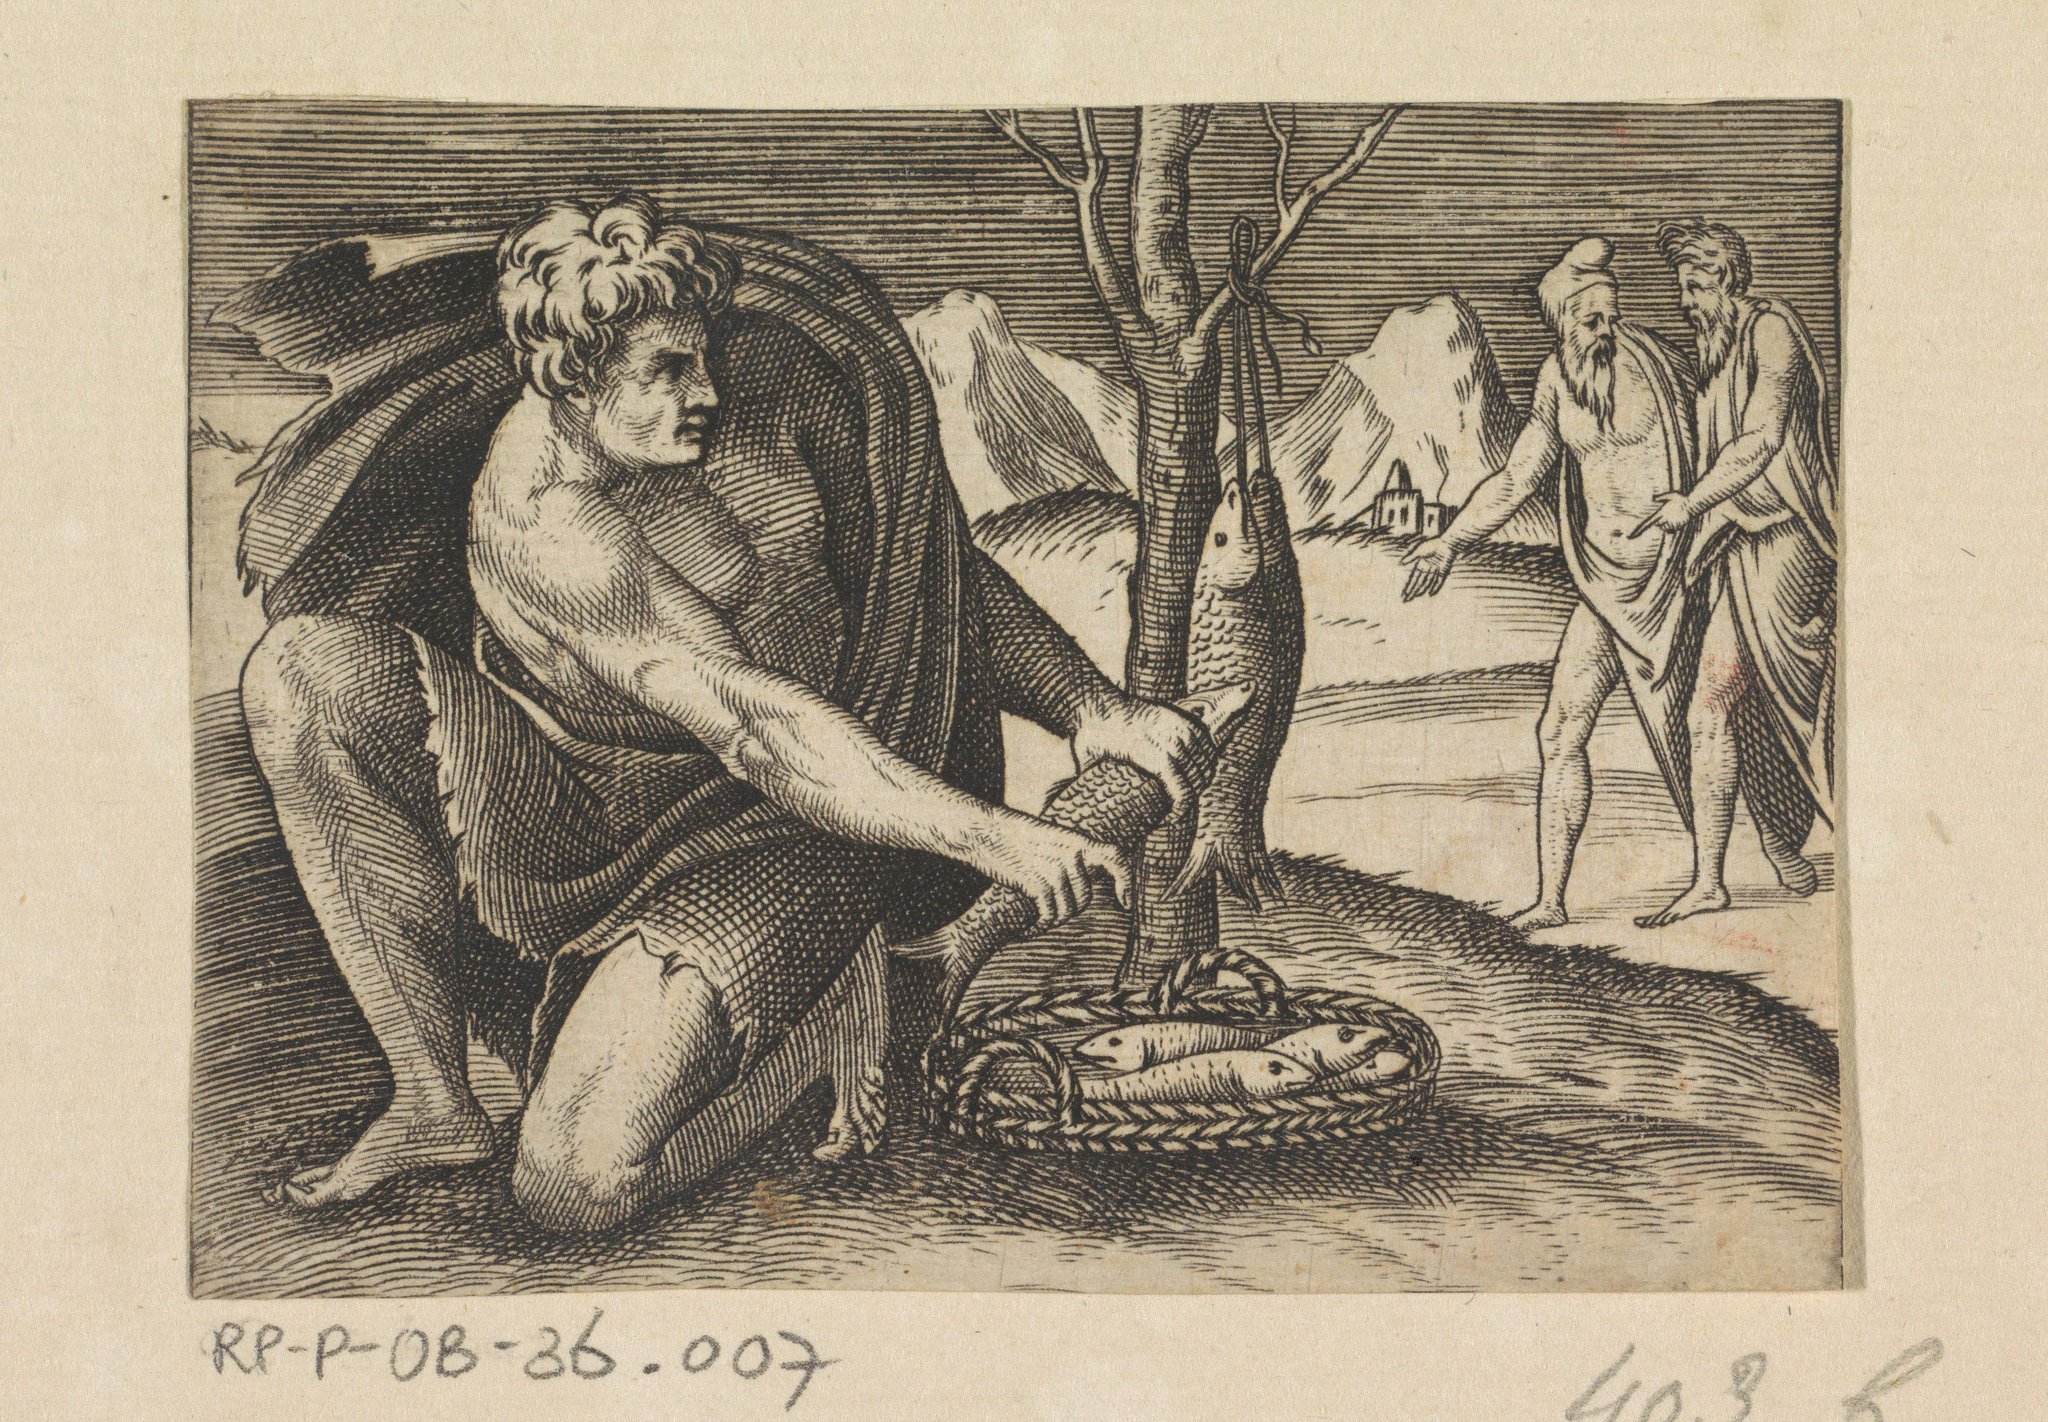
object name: print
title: Visser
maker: marco dente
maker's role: print maker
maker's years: 1486-1527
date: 1498-1532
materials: paper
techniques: engraving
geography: italy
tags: fishes, fisherman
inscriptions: collector's mark: Lugt 12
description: Een visser zit geknield naast een boom waarin vissen hangen. Onder de boom staat een mandje met vissen. Op de achtergrond lopen twee mannen.